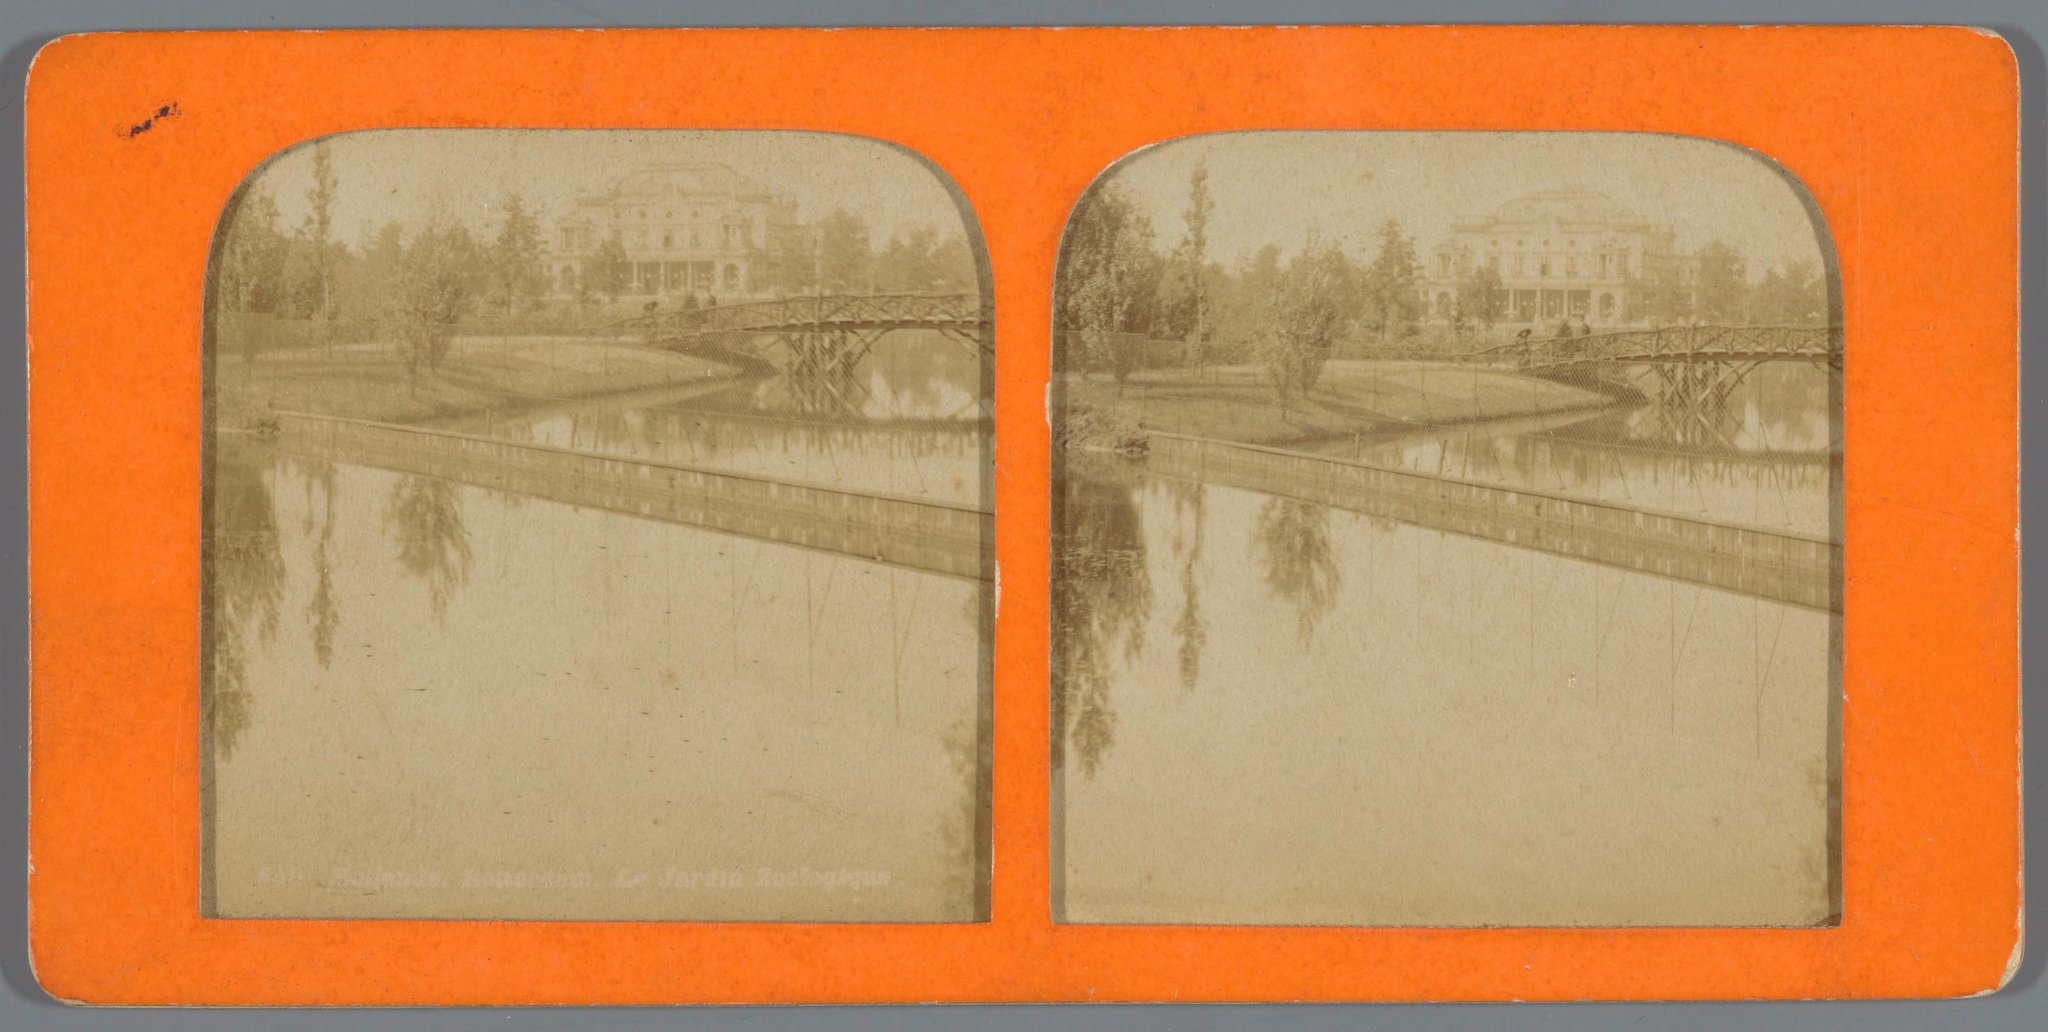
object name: tissue stereograph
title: Gezicht op vermoedelijk Diergaarde Blijdorp in Rotterdam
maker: Anonymous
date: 1855-1875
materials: cardboard, paper, photographic support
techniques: albumen print, cutting, hand coloring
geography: rotterdam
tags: zoological garden, zoo, seen as place where non-domestic animals are kept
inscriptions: number: ‘7’, inscription: ‘Rotterdam, Diergaarde’